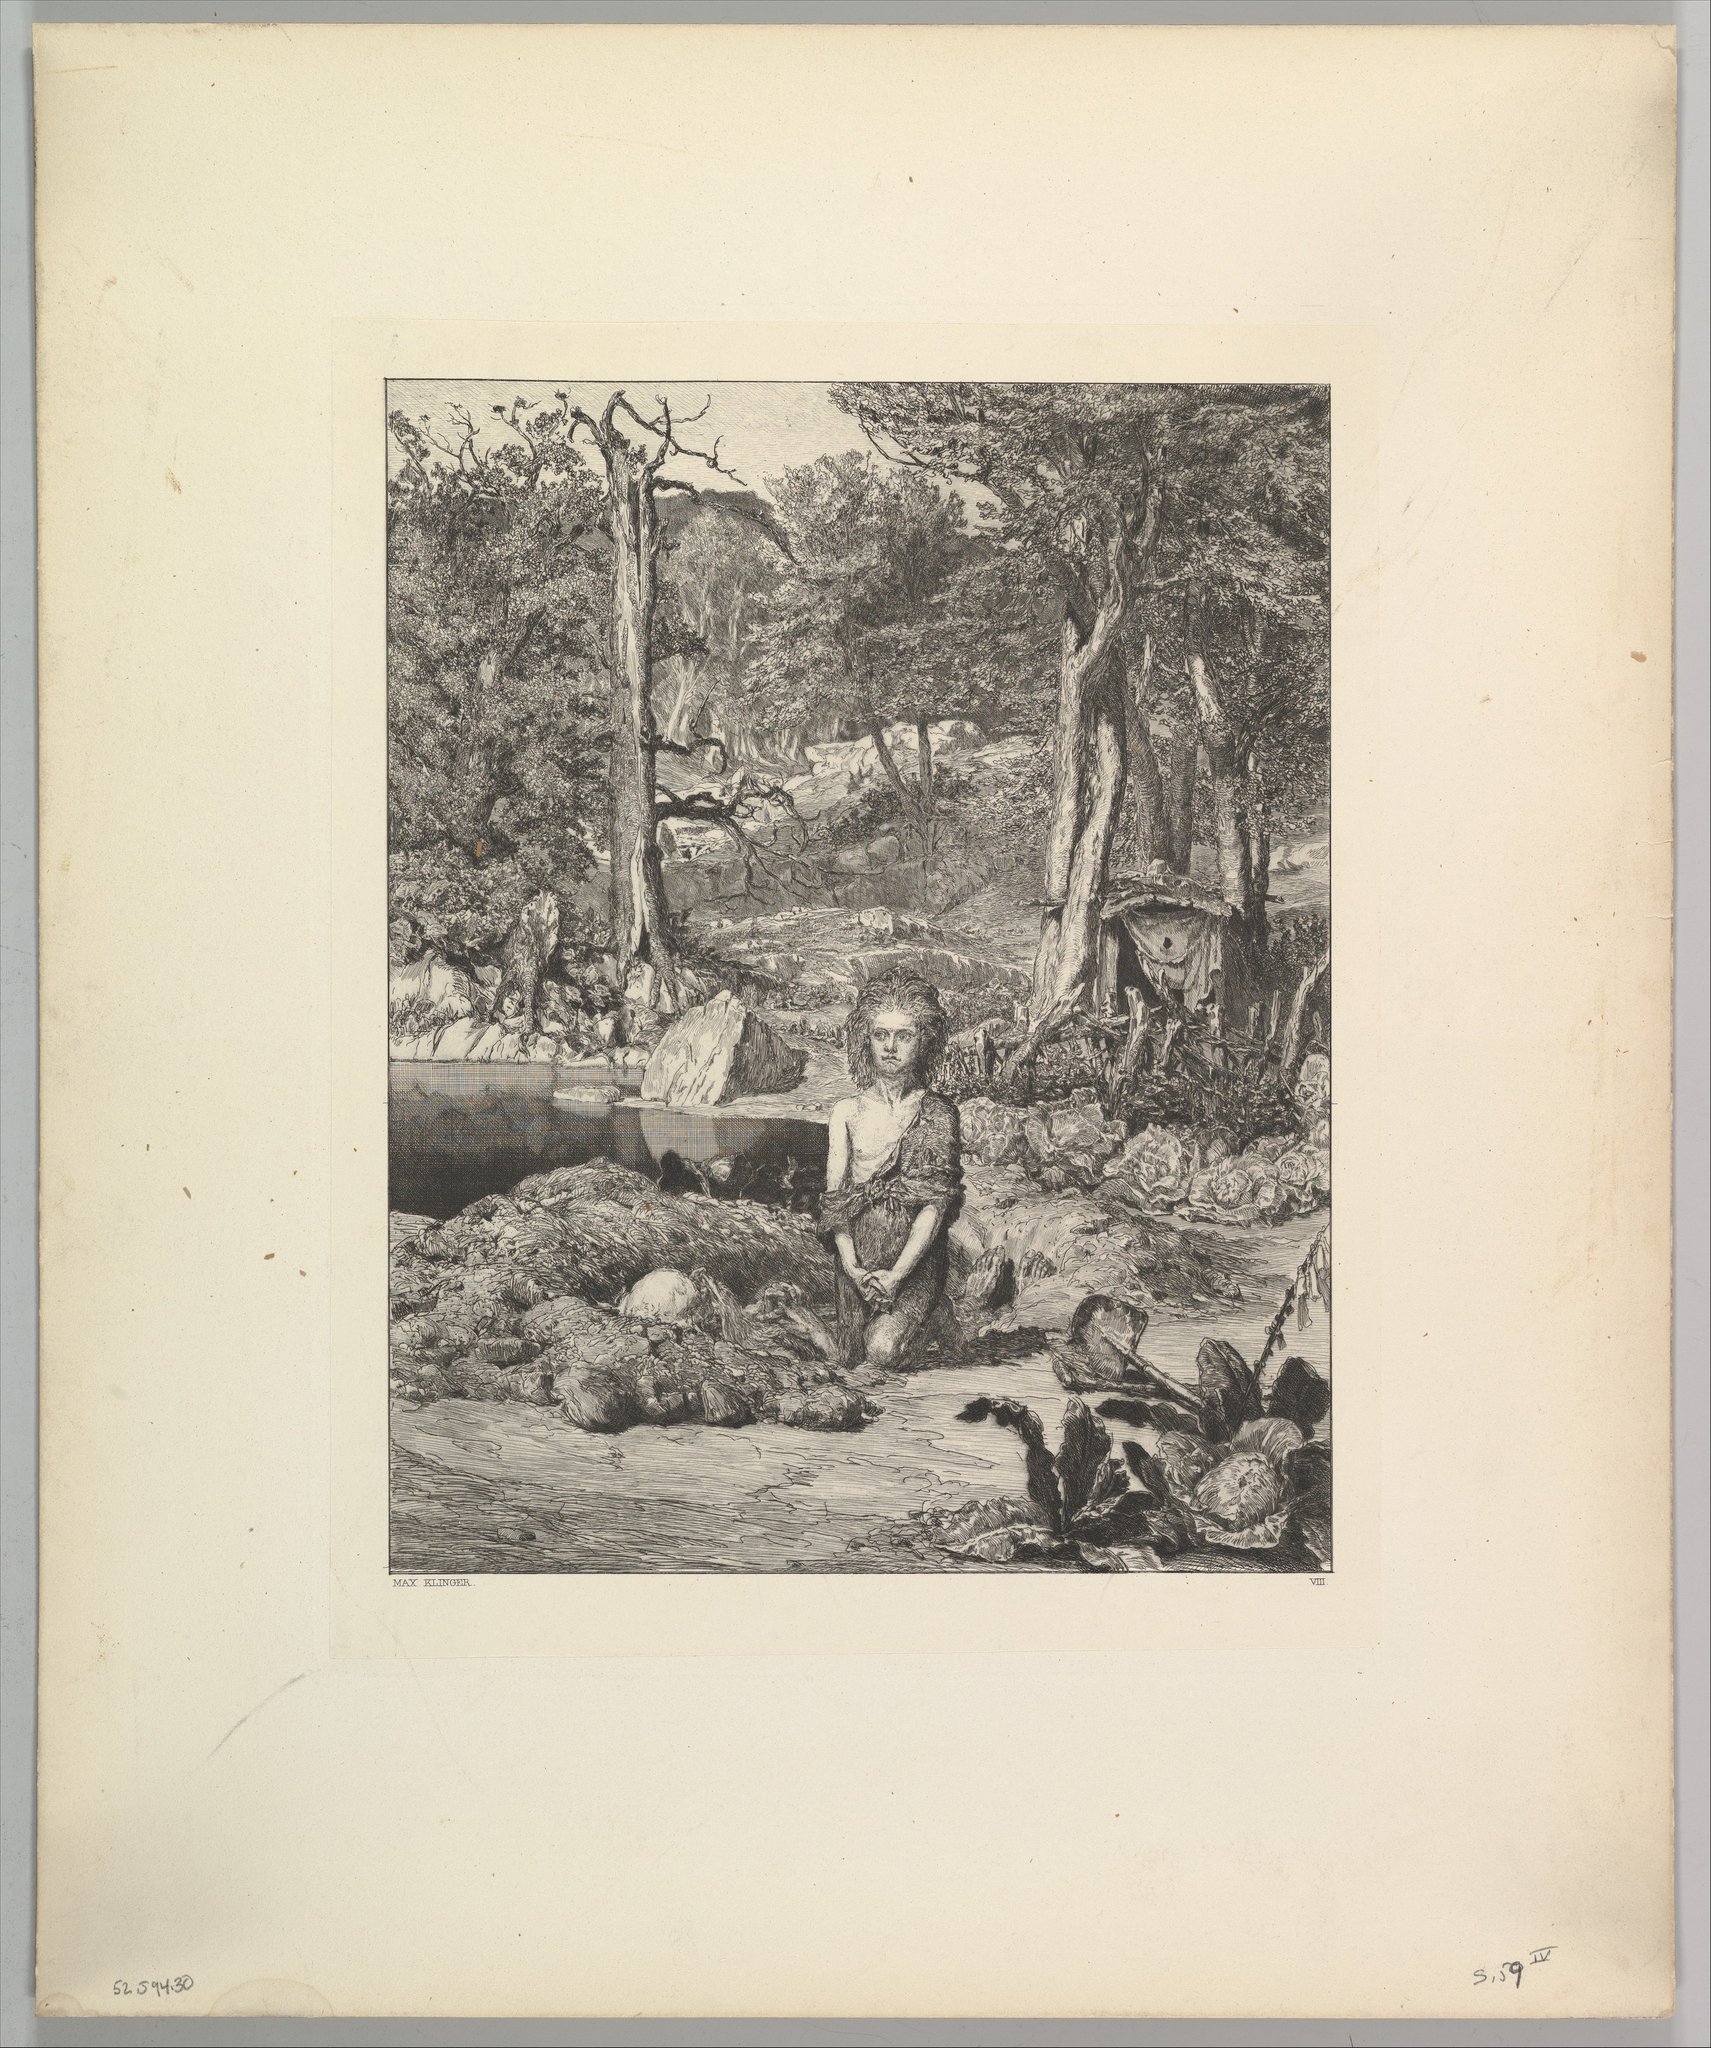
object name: print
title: Simplicius am Grabe des Einsiedlers, from the series Intermezzi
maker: max klinger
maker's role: artist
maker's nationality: german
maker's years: 1857-1920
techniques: aquatint, printmaking, etching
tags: girls,trees